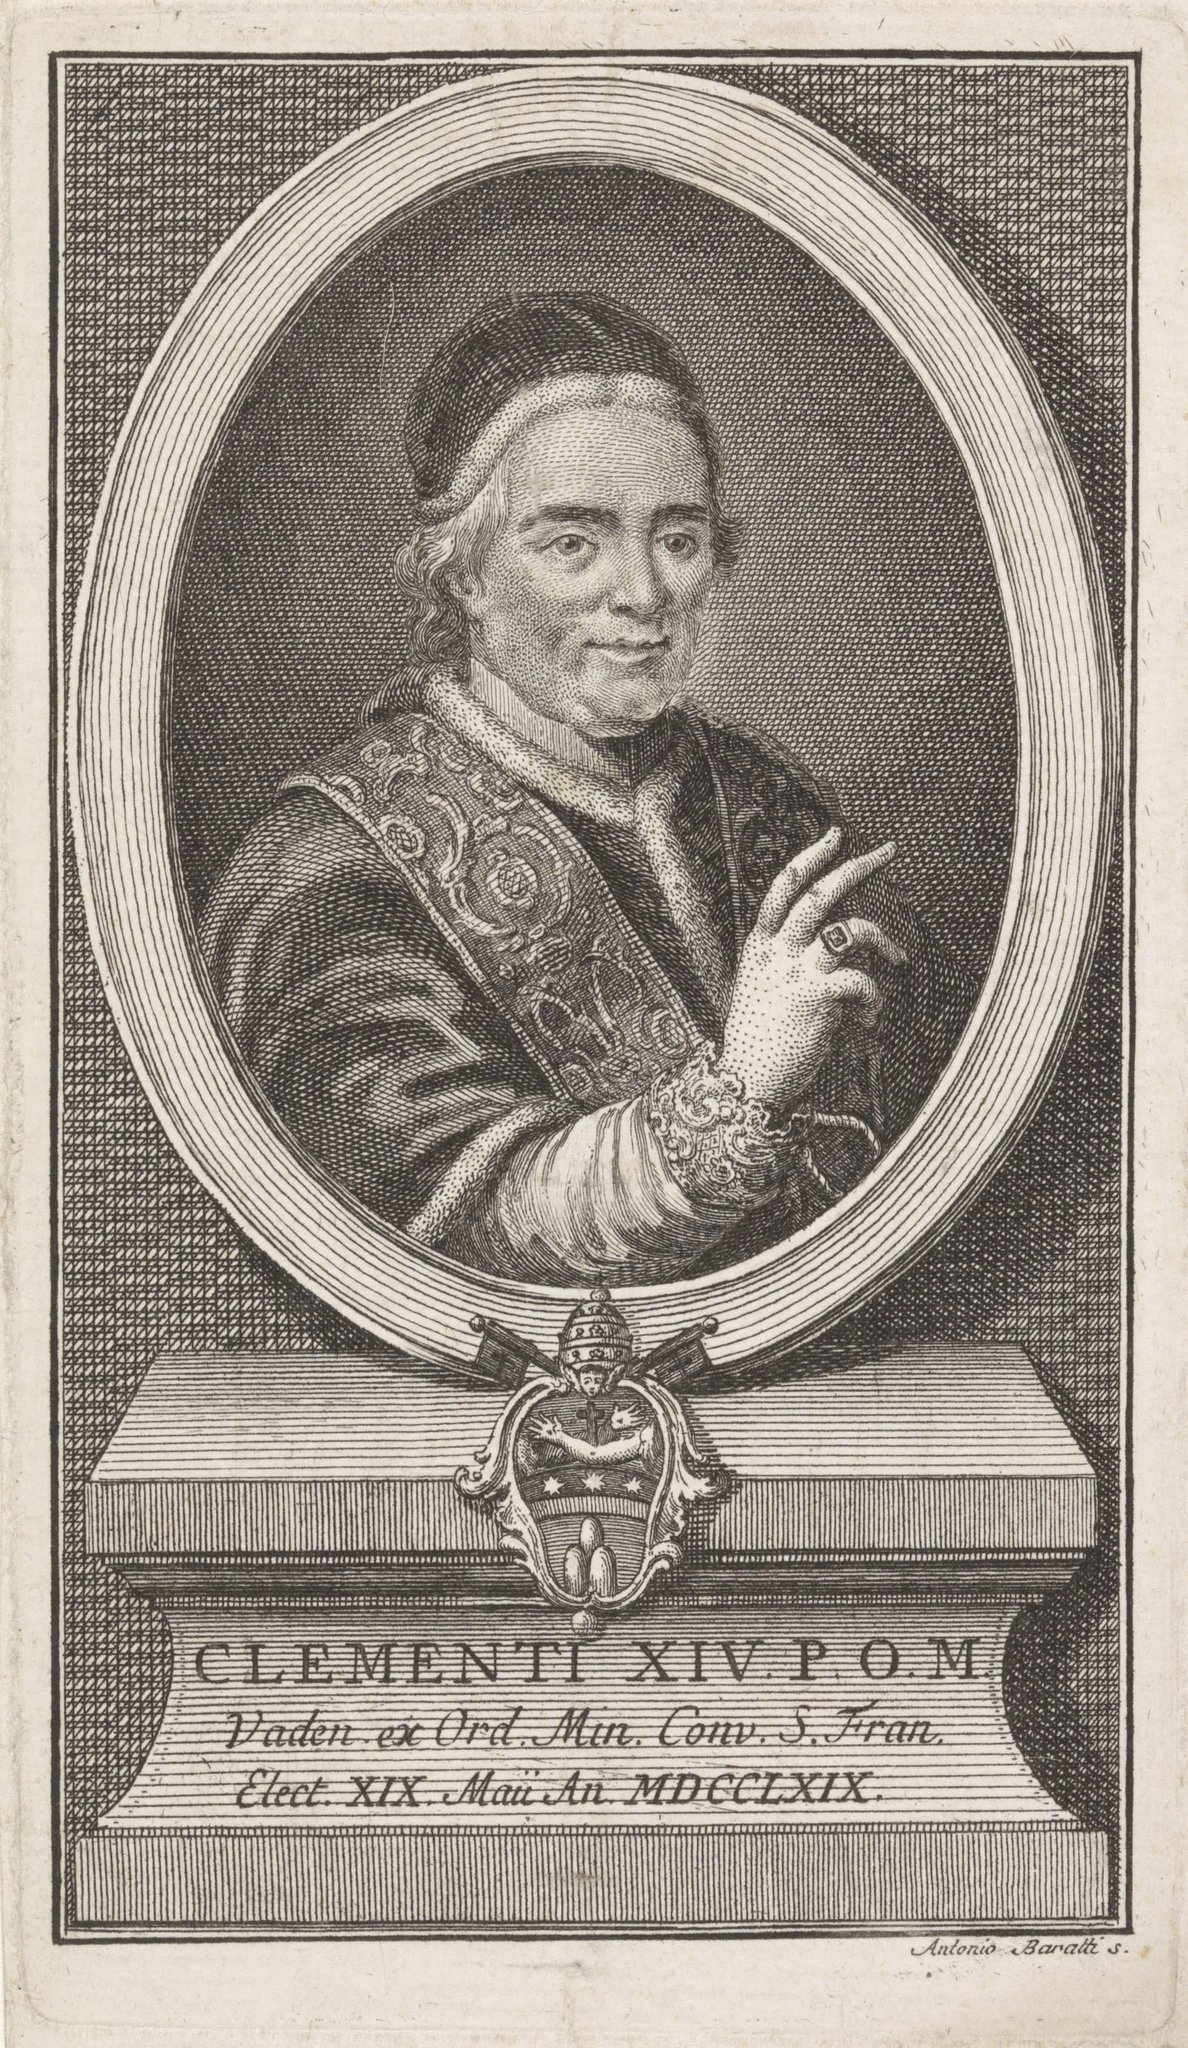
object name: print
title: Portret van paus Clemens XIV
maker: antonio baratta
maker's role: print maker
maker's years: 1724-1787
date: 1734-1787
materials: paper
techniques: engraving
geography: italy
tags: rome, pope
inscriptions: collector's mark: Lugt 2228